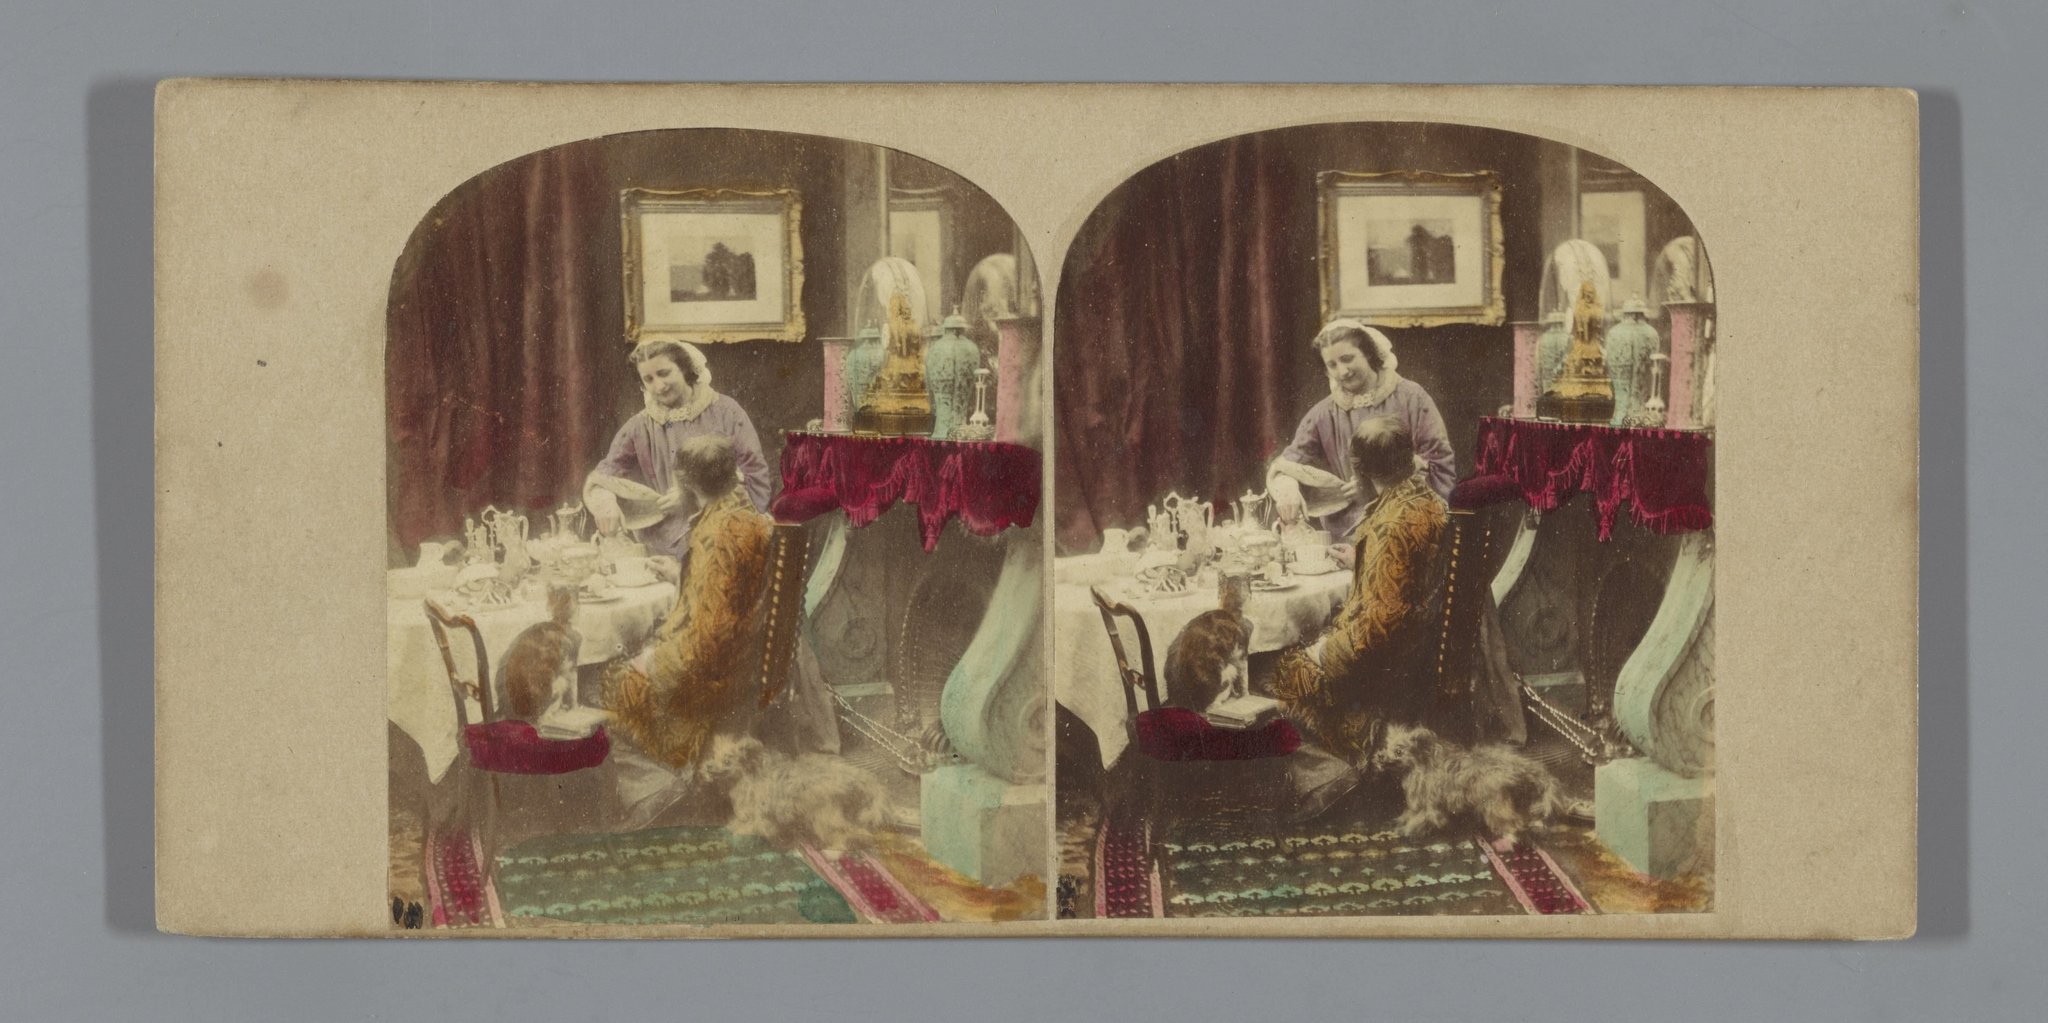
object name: stereograph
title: Five Weeks after Marriage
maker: james elliott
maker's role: publisher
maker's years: 1832-1900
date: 1856-1861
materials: cardboard, paper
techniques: albumen print, hand coloring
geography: london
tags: breakfast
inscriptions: inscription: ‘Entered at Stationers' Hall.’, stamp: ‘J. C. Meerburg/ Leijden’